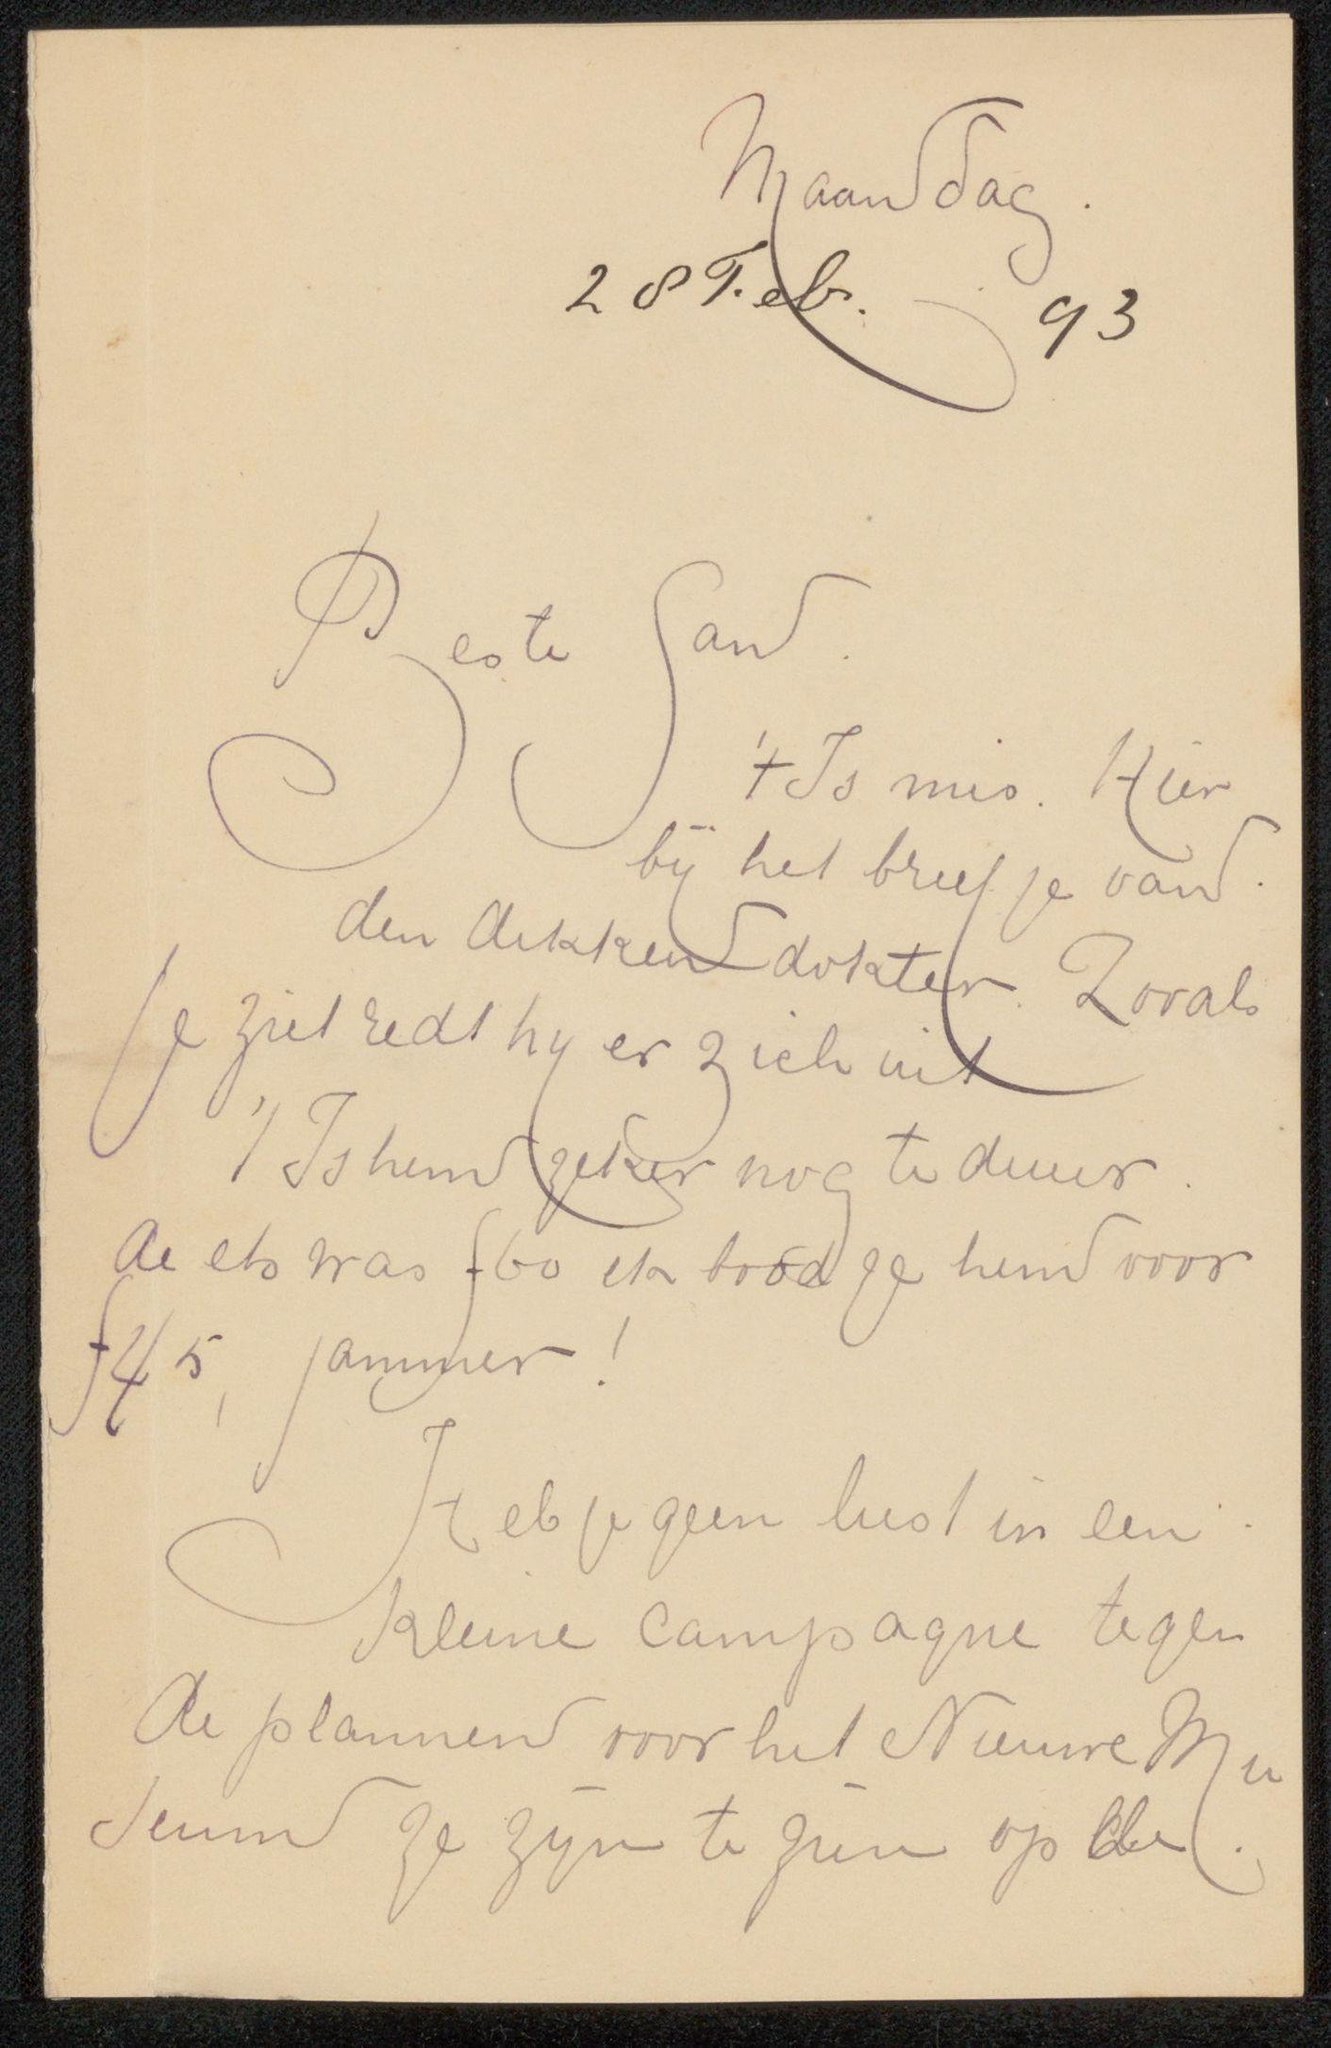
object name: letter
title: Brief aan Jan Veth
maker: andré jolles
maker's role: journalist, kunsthistoricus, letterkundige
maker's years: 1874-1946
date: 1893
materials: ink, paper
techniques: pen, writing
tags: dordrecht, amsterdam, painter, draughtsman, designer, jan veth, museum, the graphic arts, money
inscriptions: collector's mark: ‘RPK’, watermark